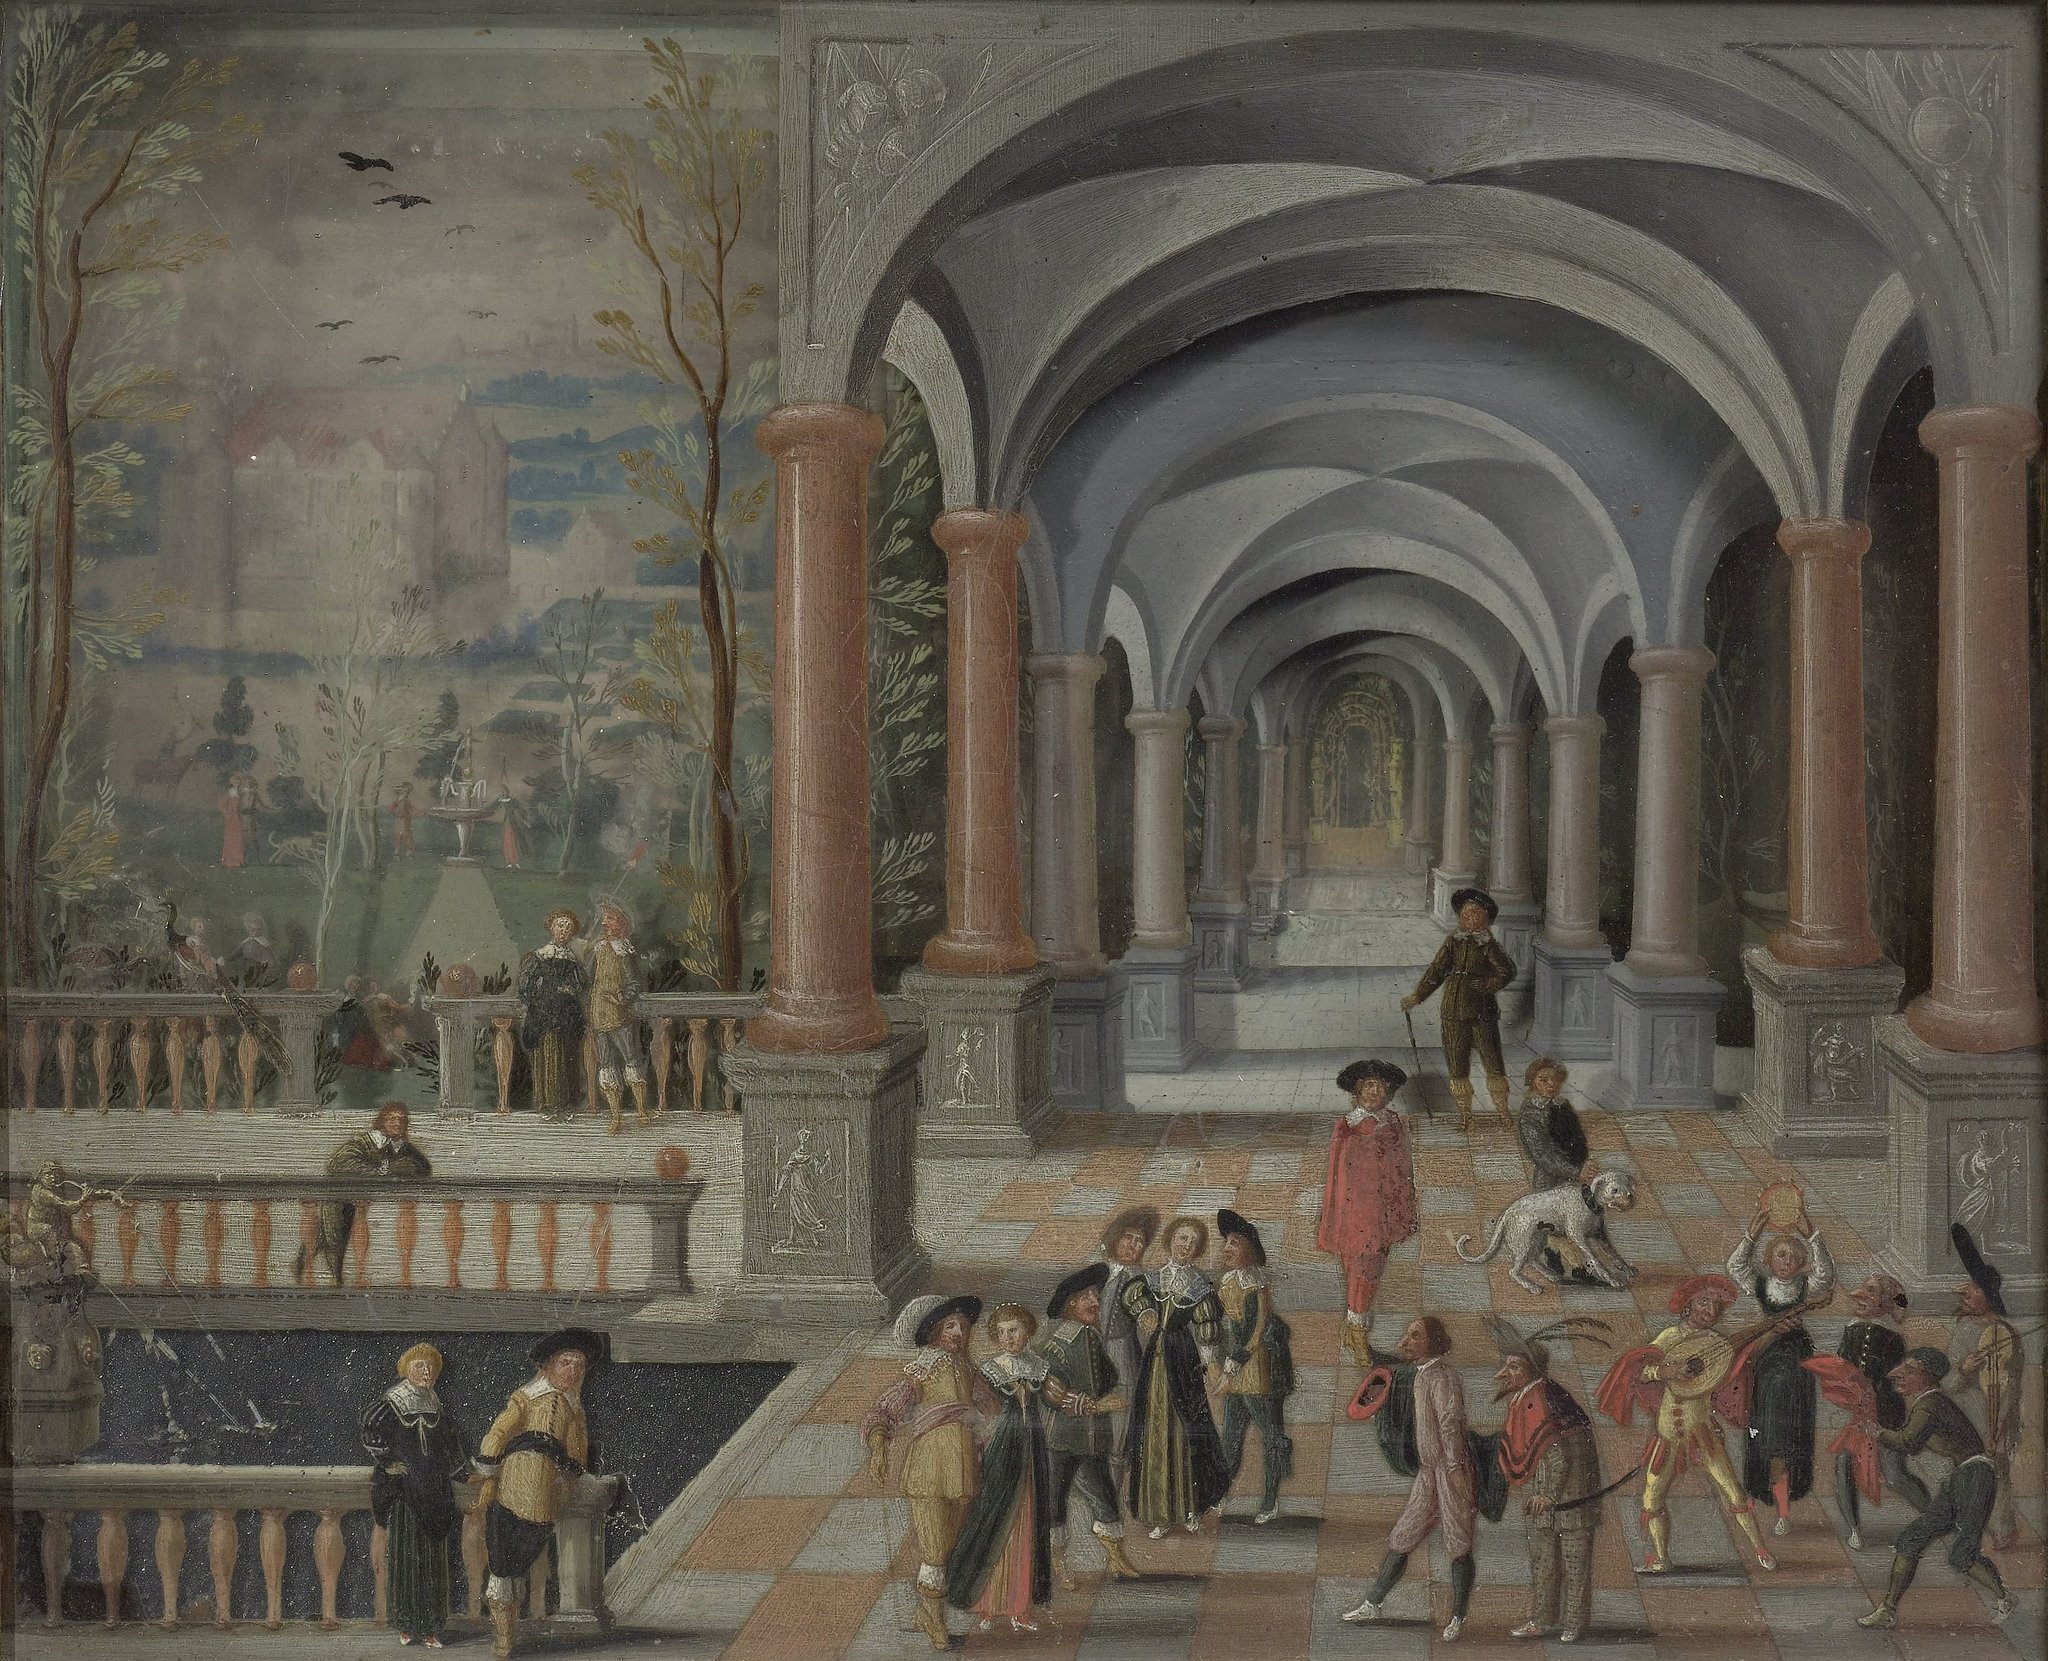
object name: painting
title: Festive Gathering and Figures from a Commedia dell'Arte in a Gallery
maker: monogrammist db (schilder)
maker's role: painter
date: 1634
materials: amalgam, glass, oil, panel, paper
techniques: glass painting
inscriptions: signature and date: ‘D.B. 1634’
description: Perspectiefkast met een voorstelling van een feestvierend gezelschap en figuren uit de Commedia dell'Arte in een galerij. Enkele elegante paren kijken naar de groep komedianten. Links een vijver met een fontein, op de achtergrond een tuin.